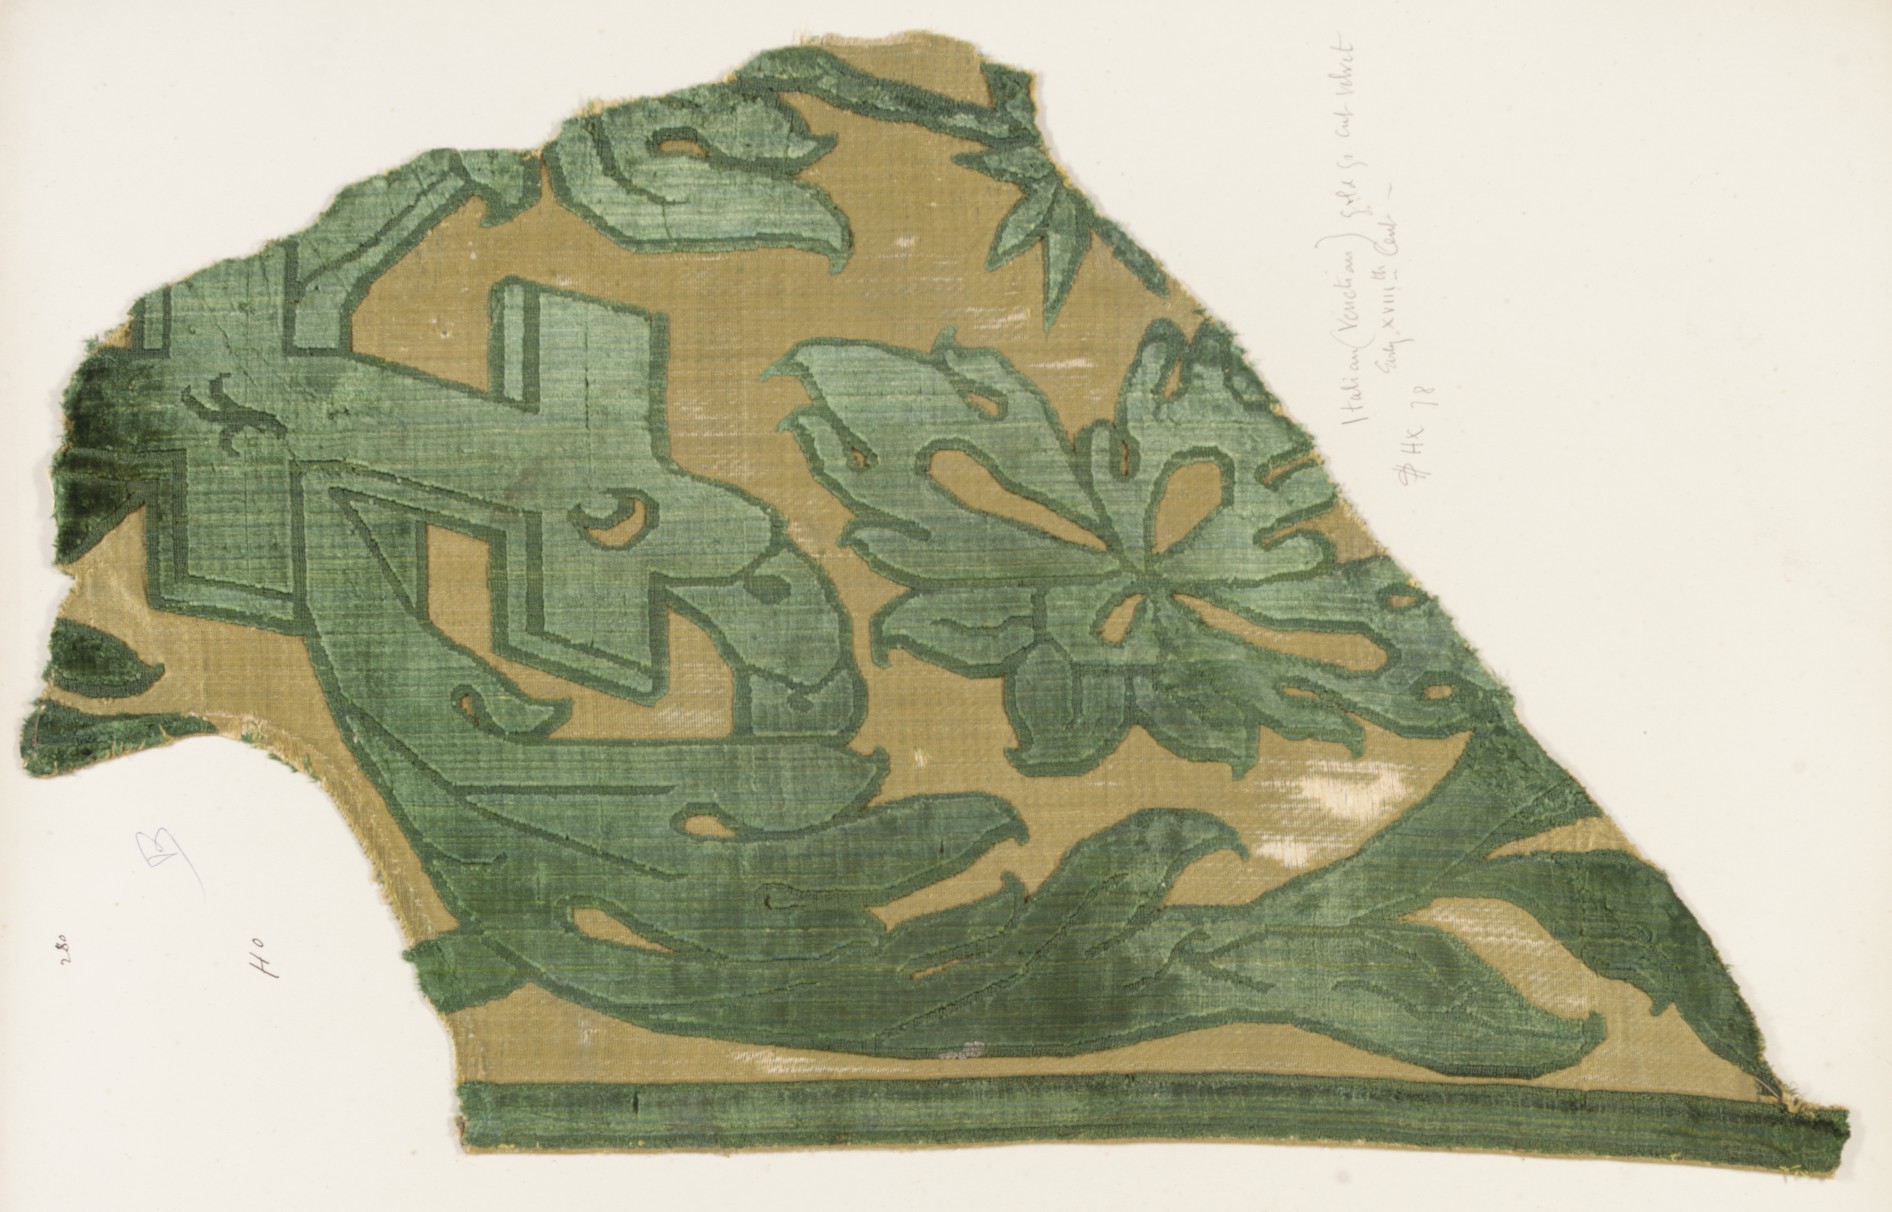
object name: fragment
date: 1701-1733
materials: silk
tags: leaves